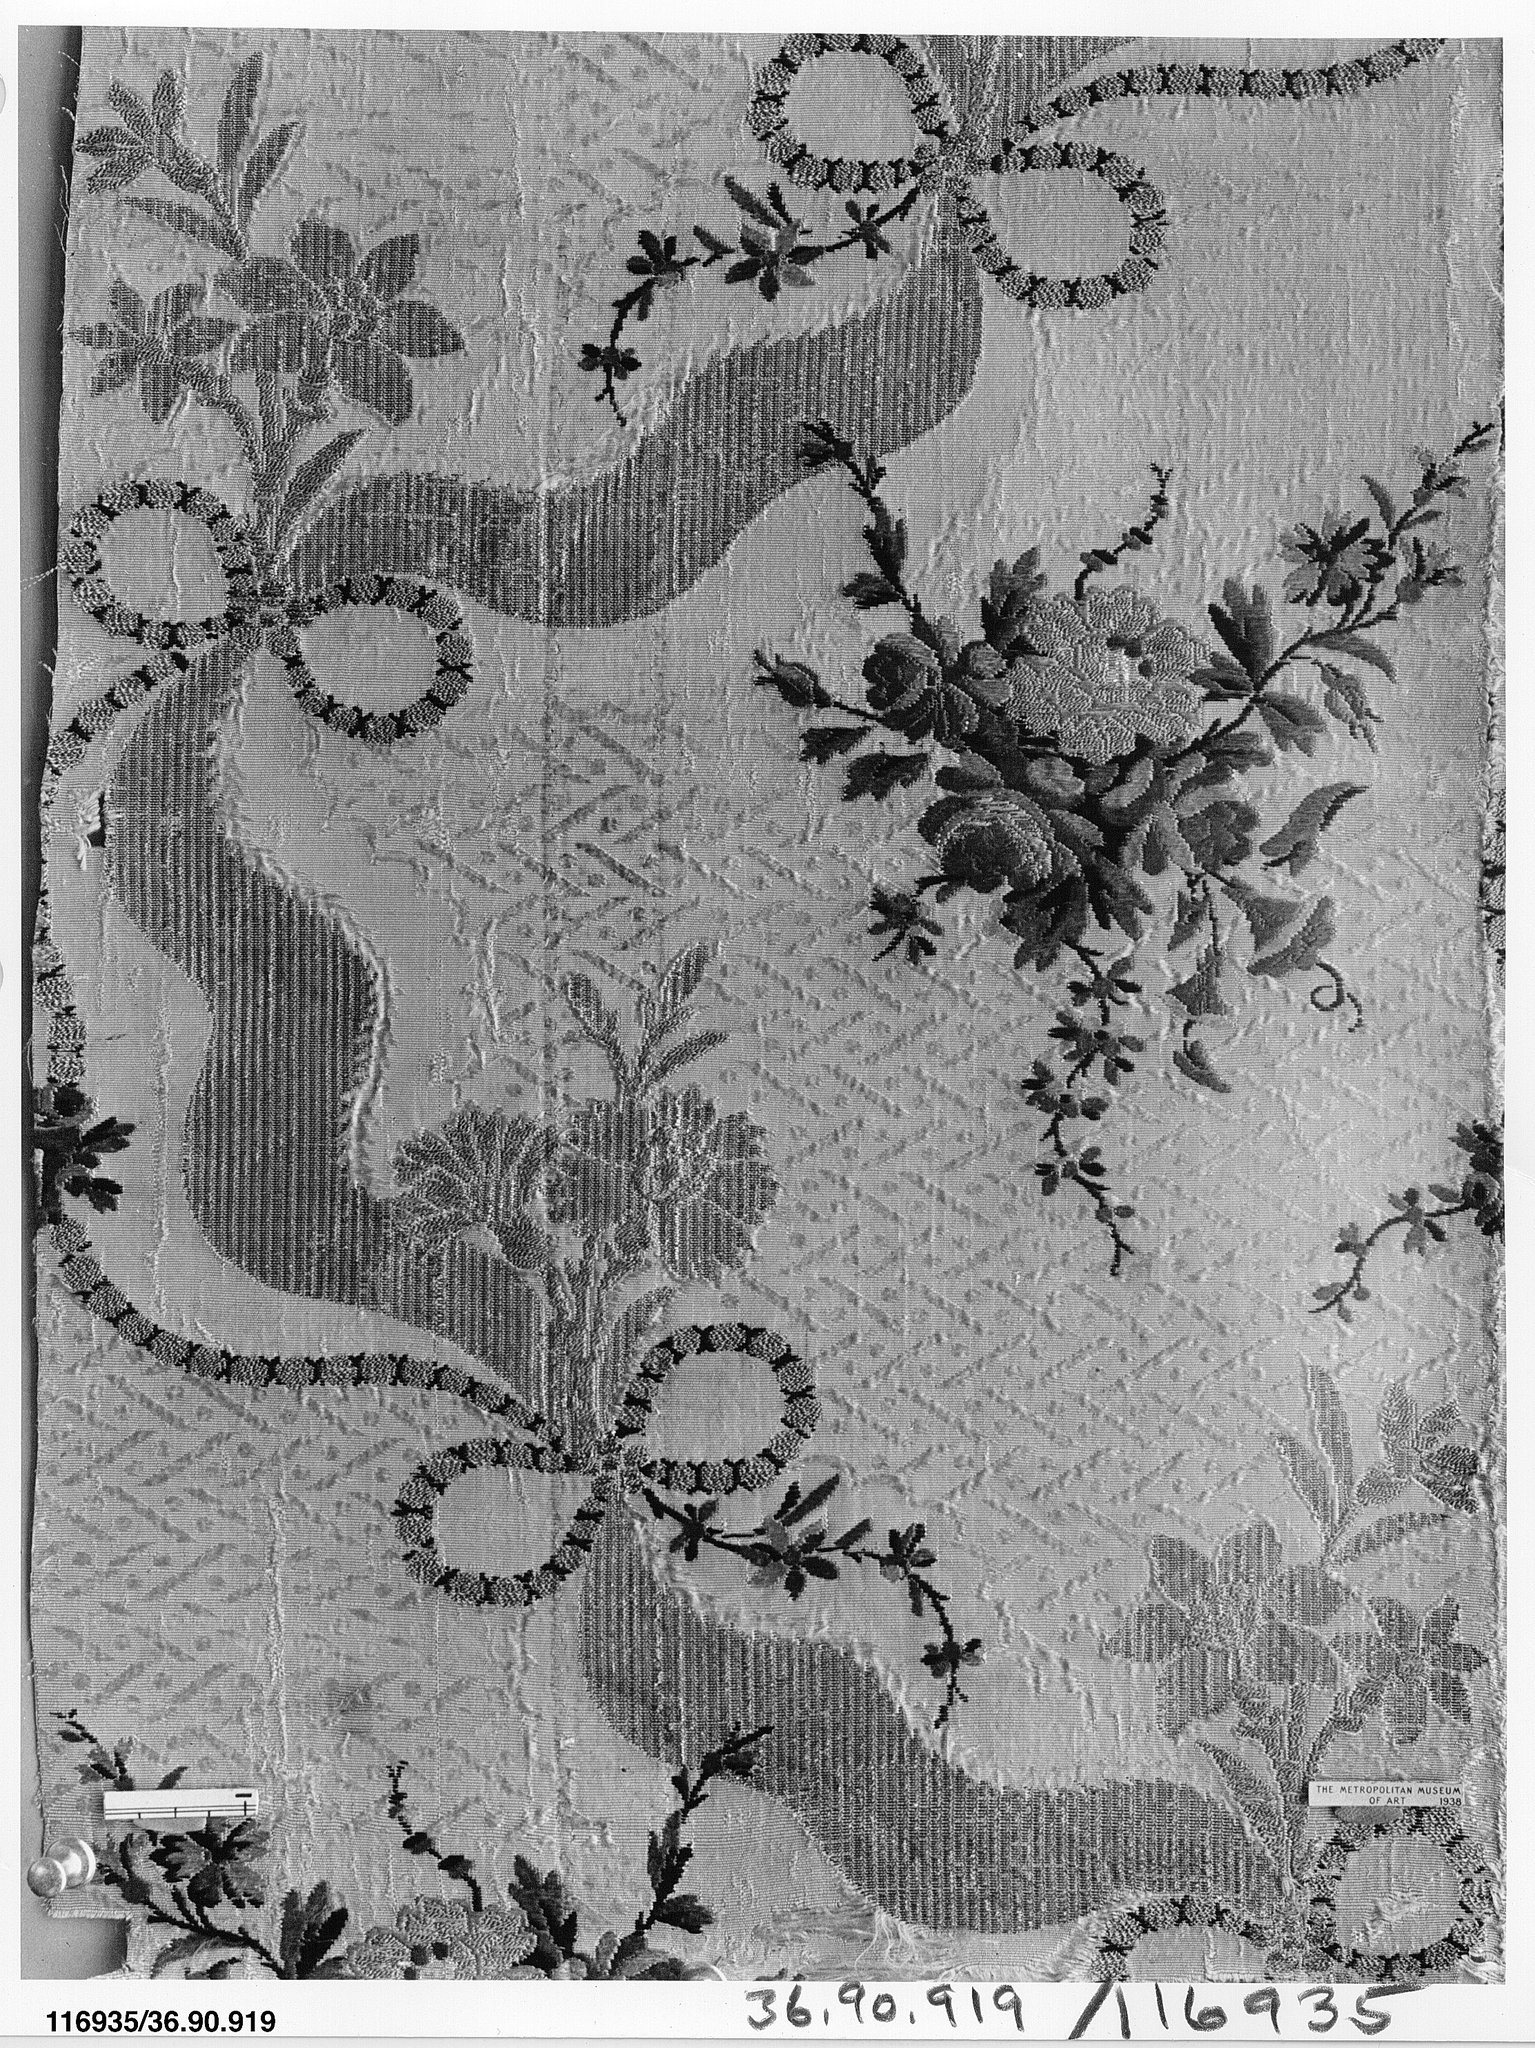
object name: piece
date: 1750-1760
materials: metal thread, silk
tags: flowers,leaves